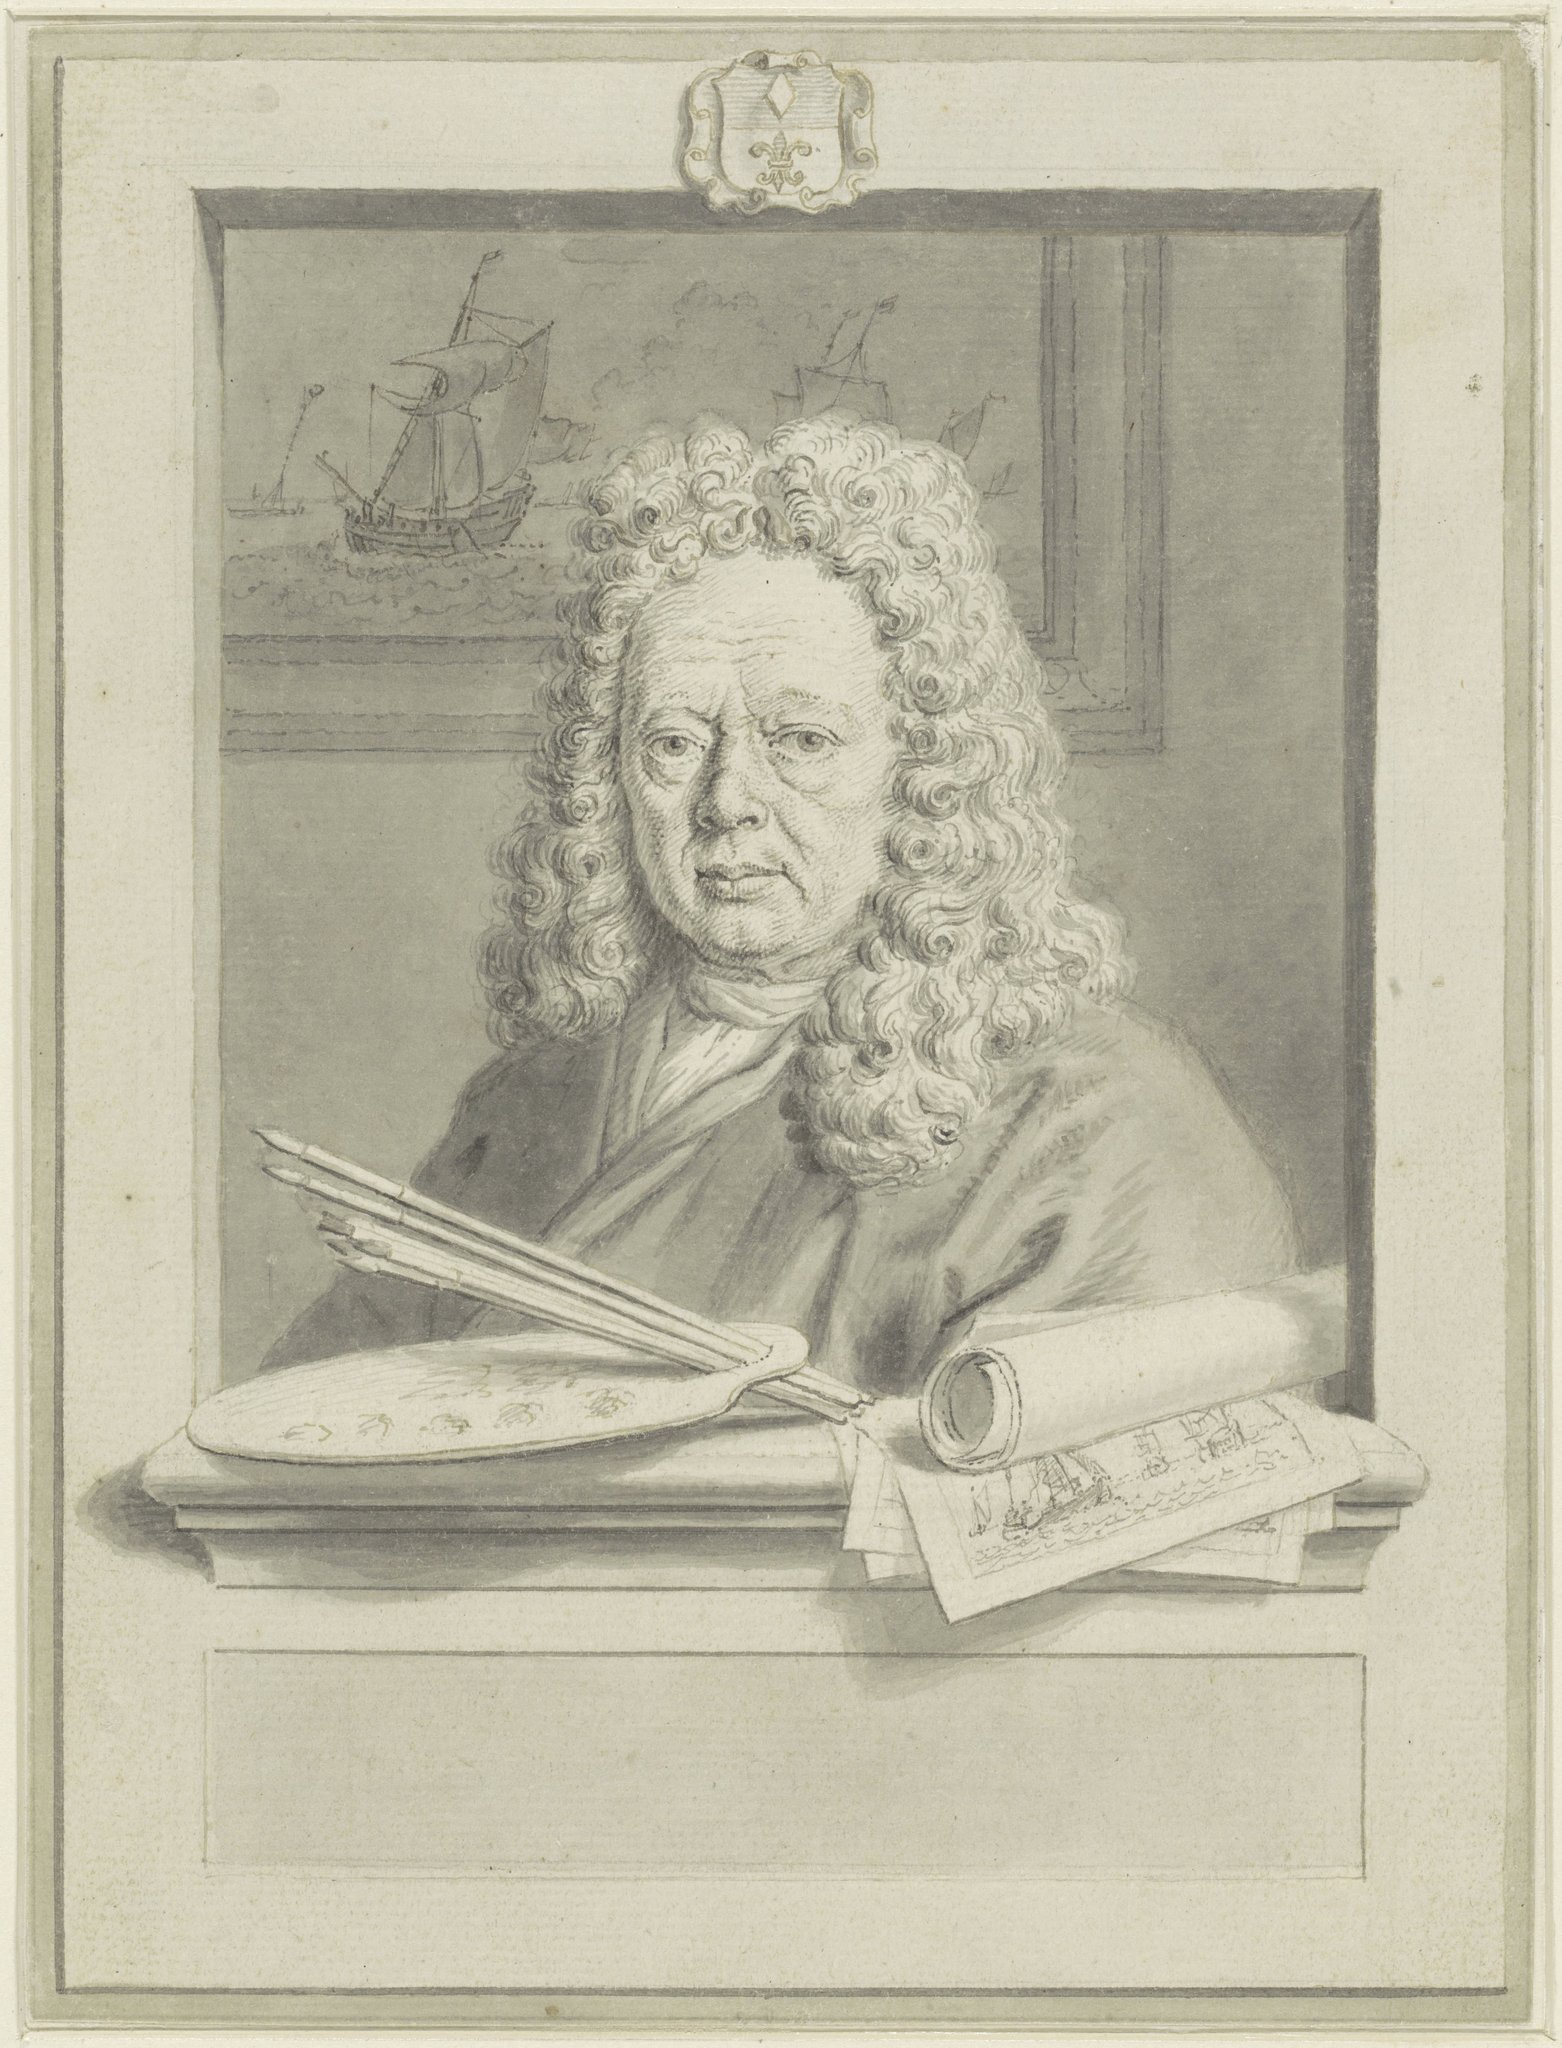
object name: drawing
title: Portret van Wigerus Vitringa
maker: tako hajo jelgersma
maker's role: draughtsman, painter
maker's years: 1702-1795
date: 1712-1795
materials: ink, paper, pencil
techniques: brush, pen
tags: draughtsman, wigerus vitringa, historical persons, portrait, self-portrait of painter, portrait, self-portrait of artist, portrait, self-portrait of draughtsman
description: Portret van de schilder Wigerus Vitringa.